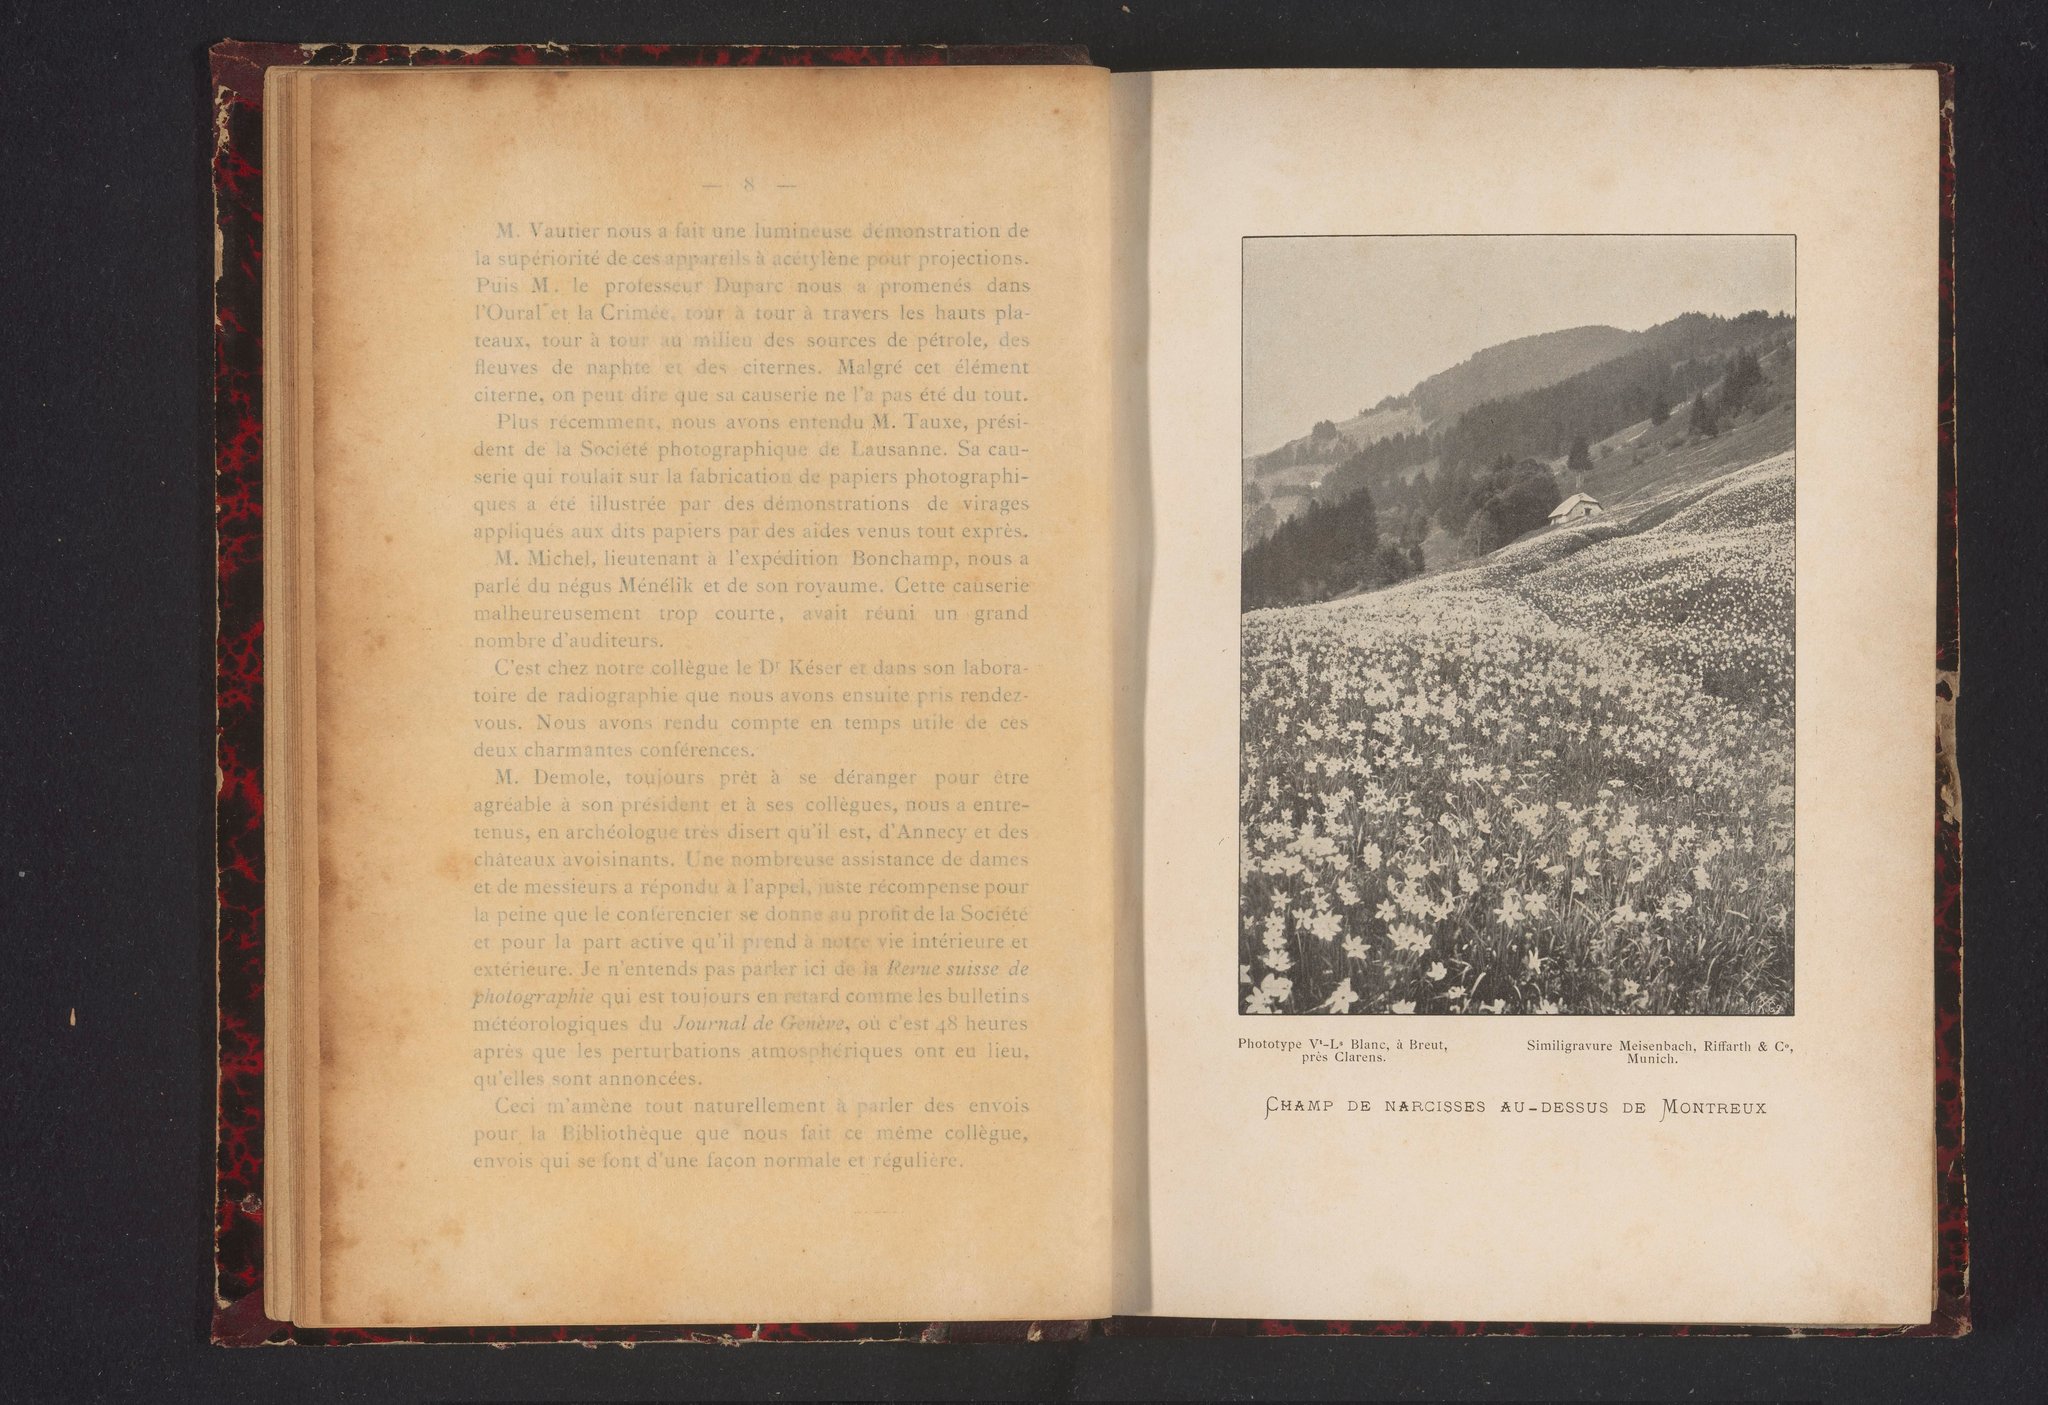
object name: photomechanical print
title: Champs de narcisses au-dessus de Montreux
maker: hoffmann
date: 1894-1899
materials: paper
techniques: autotype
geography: munich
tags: meadow, pasture, flowers: narcissus, mountains